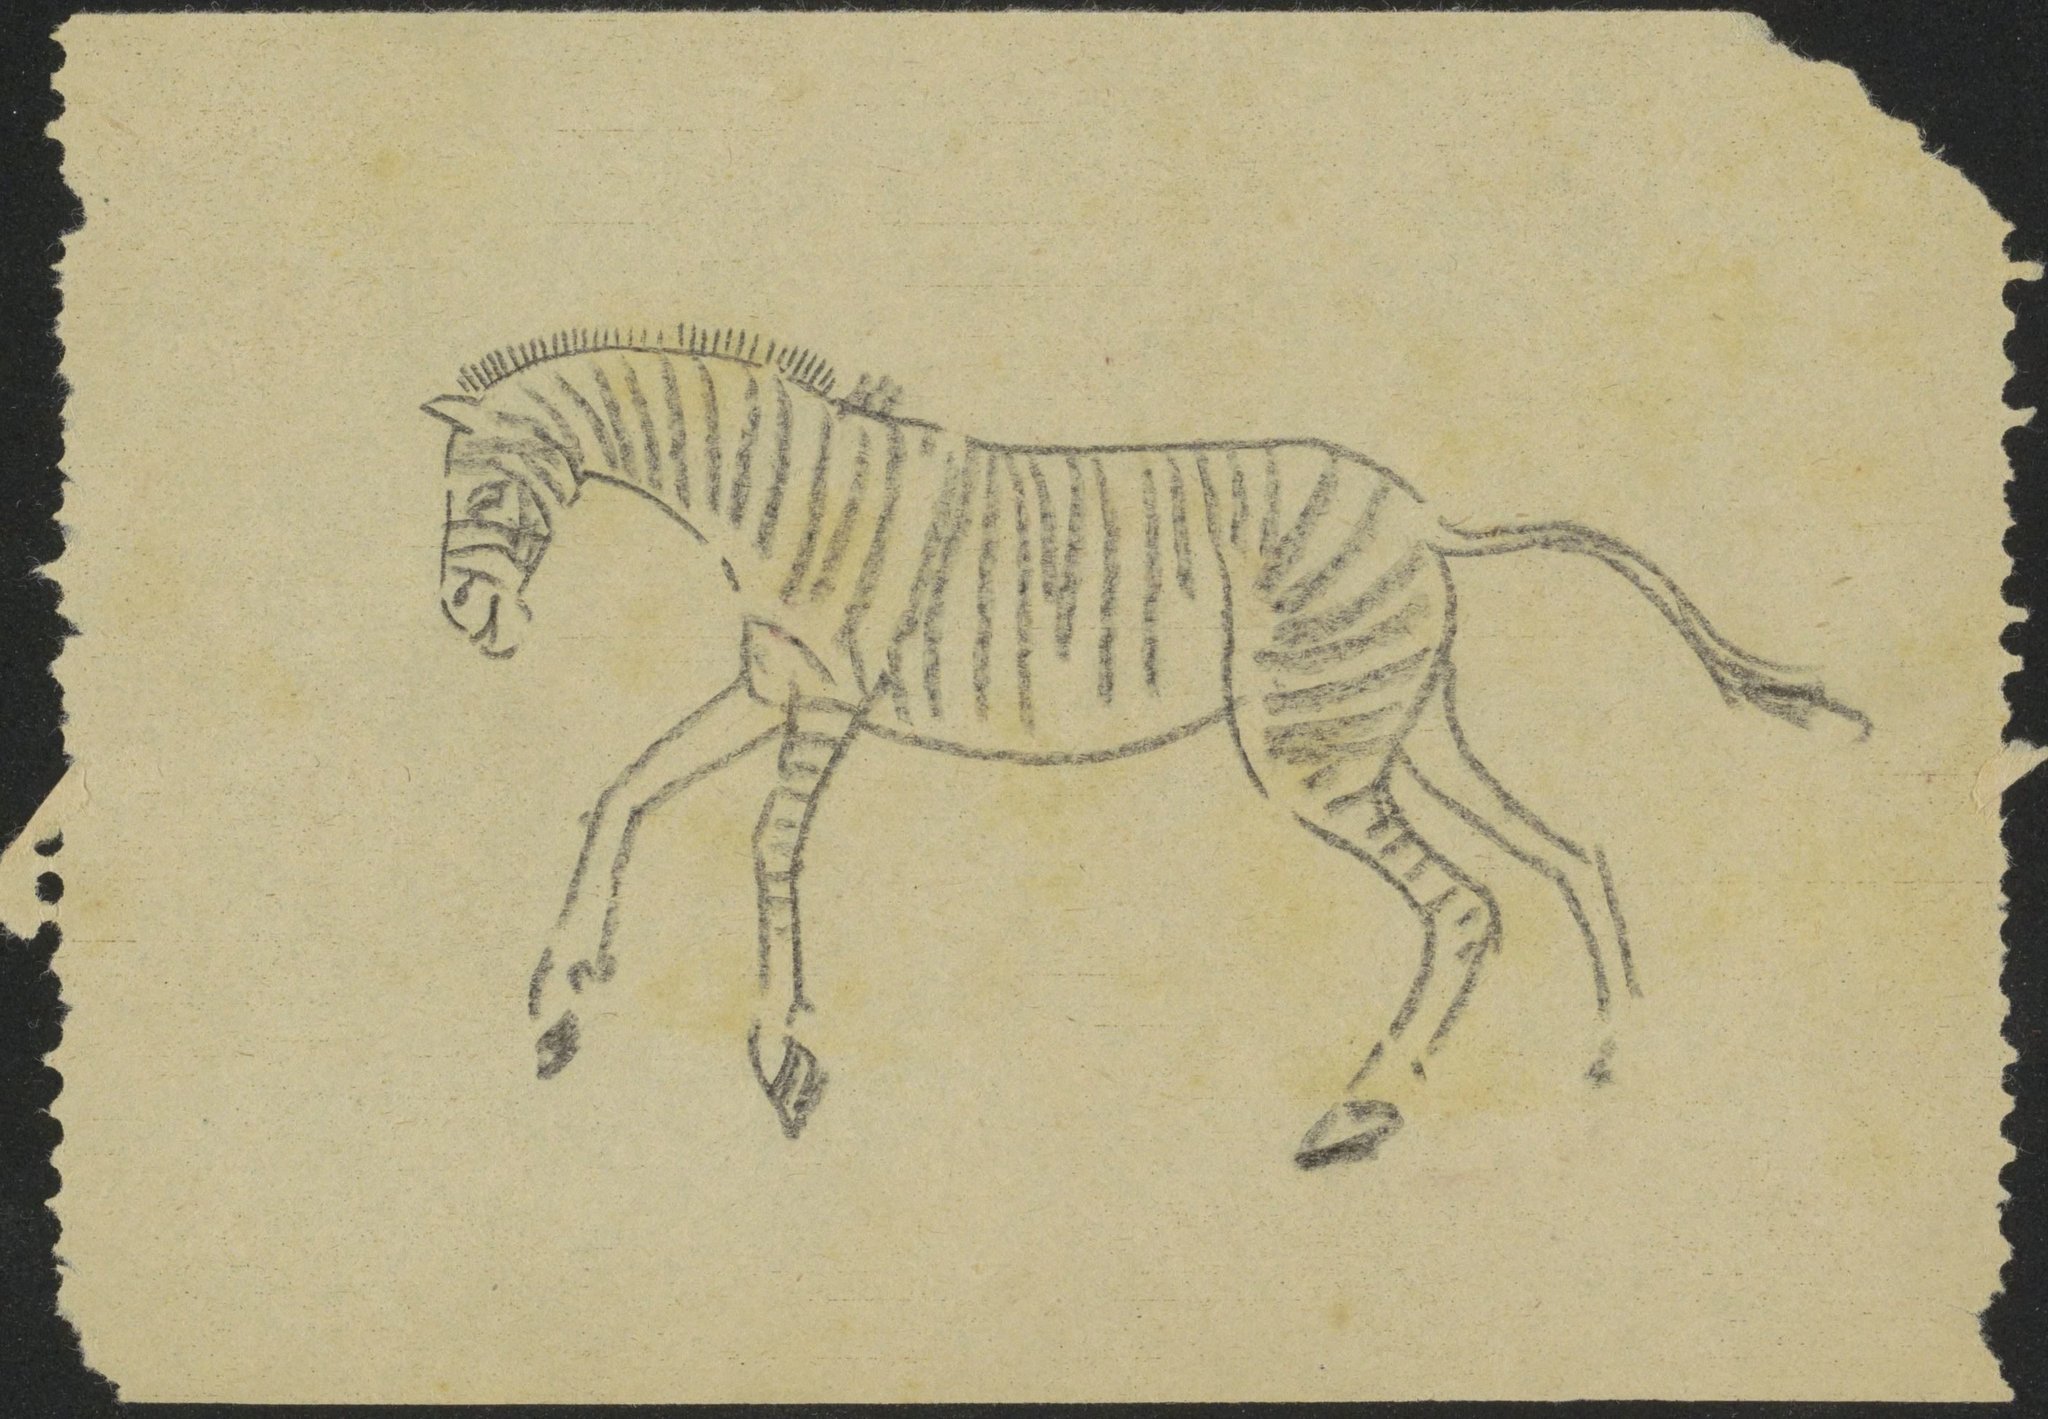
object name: drawing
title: Zebra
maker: gerrit willem dijsselhof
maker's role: designer, draughtsman, print maker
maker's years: 1866-1924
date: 1904-1906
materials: chalk, paper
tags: hoofed animals (with name)